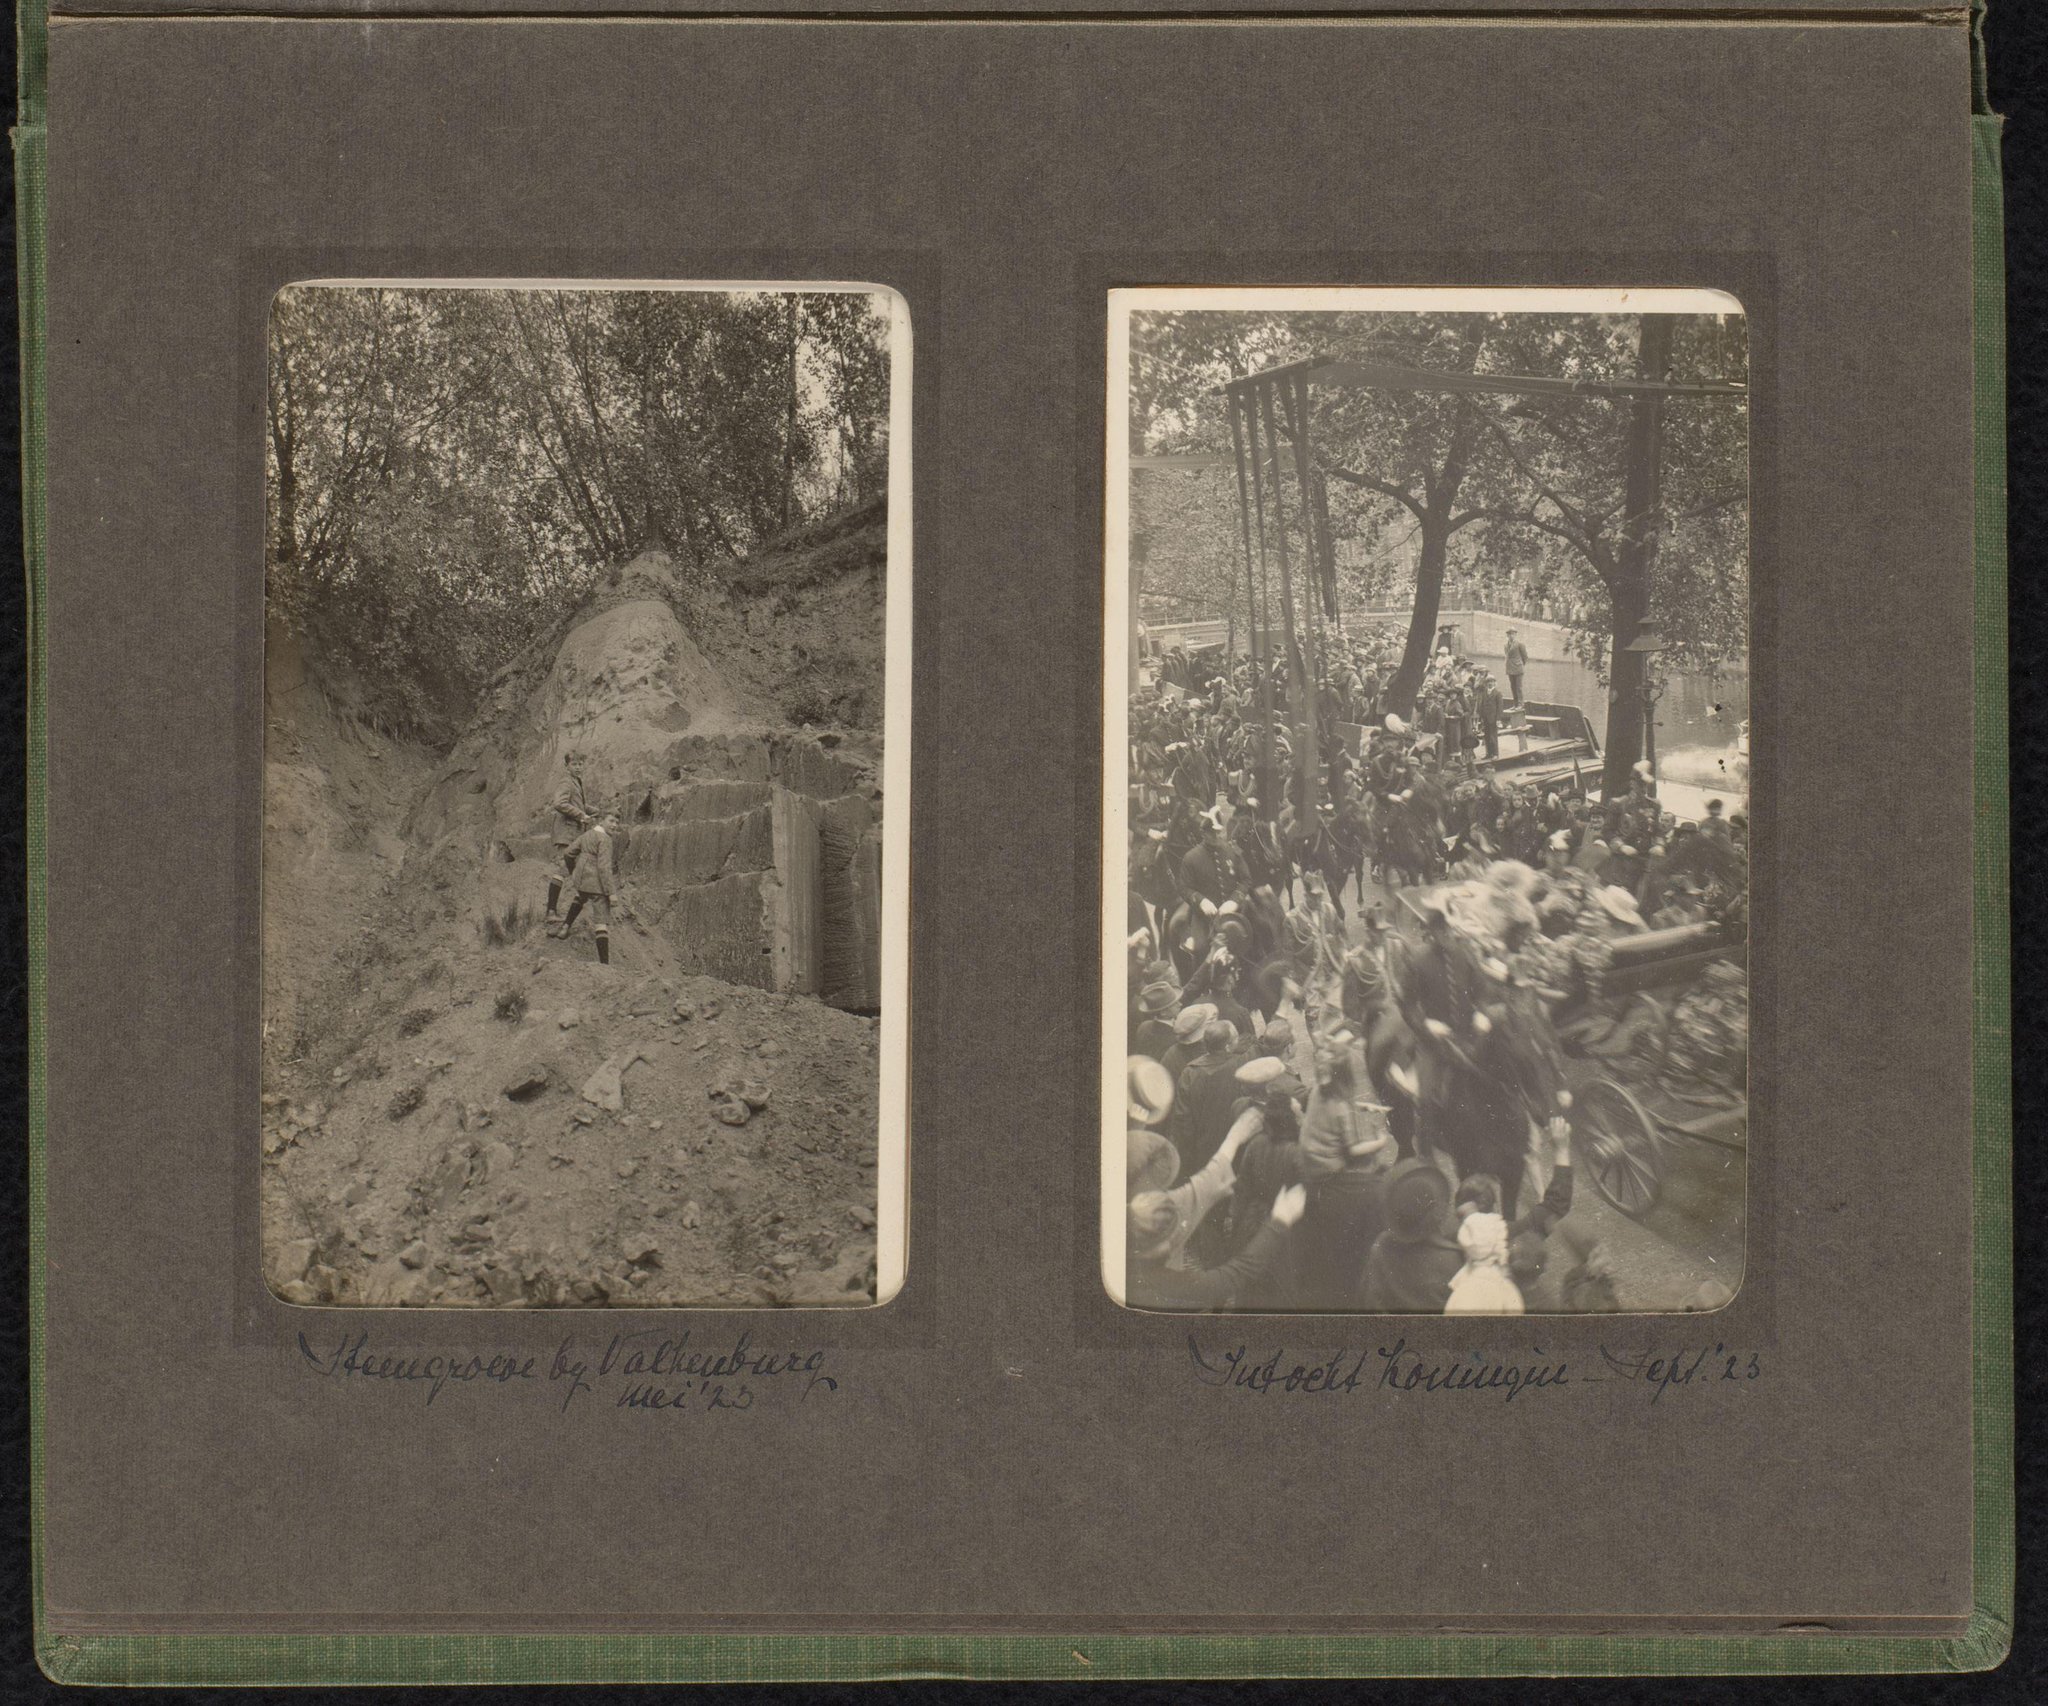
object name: photograph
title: Twee foto's van een steengroeve in Valkenburg en een optocht met koningin Wilhelmina in Amsterdam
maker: hendrik herman van den berg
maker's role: amateurfotograaf, jurist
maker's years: 1875-1944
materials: paper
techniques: gelatin silver print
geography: netherlands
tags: amsterdam, carel frederik van den berg (cay), frank willem van den berg (1912-1998), public festivities on the occasion of royal events, quarry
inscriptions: inscription: ‘Steengroeve bij Valkenburg/ Mei '23’, inscription: ‘Intocht Koningin Sept '23’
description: Deze foto's maken deel uit van een album.